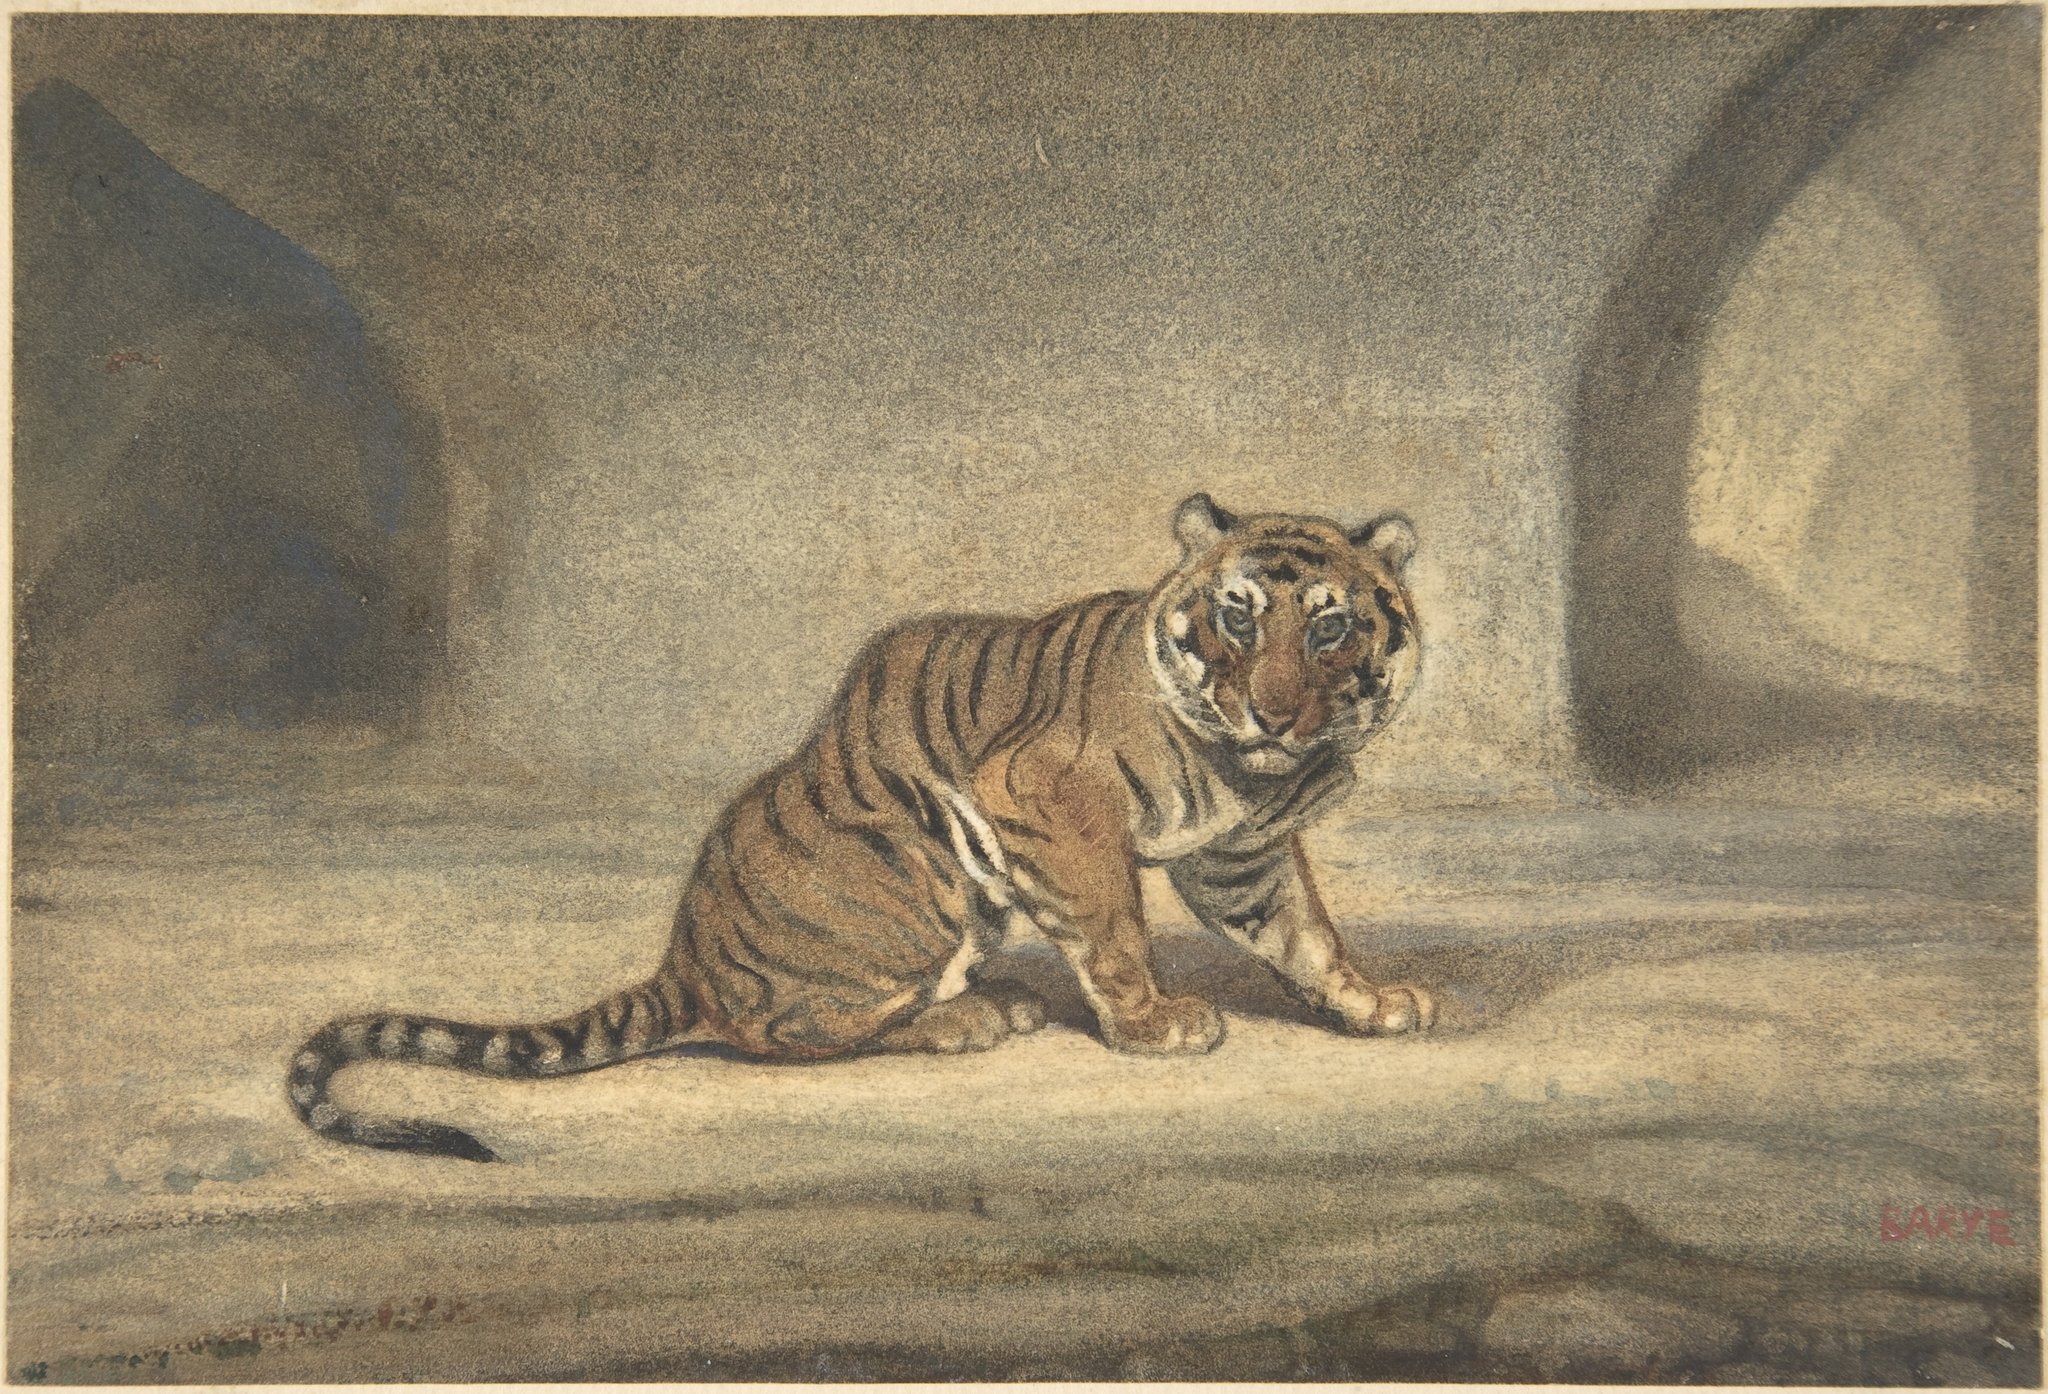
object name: drawing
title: Tiger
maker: antoine-louis barye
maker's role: artist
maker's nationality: french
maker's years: 1795-1875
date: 1810-1875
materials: watercolor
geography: france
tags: tigers